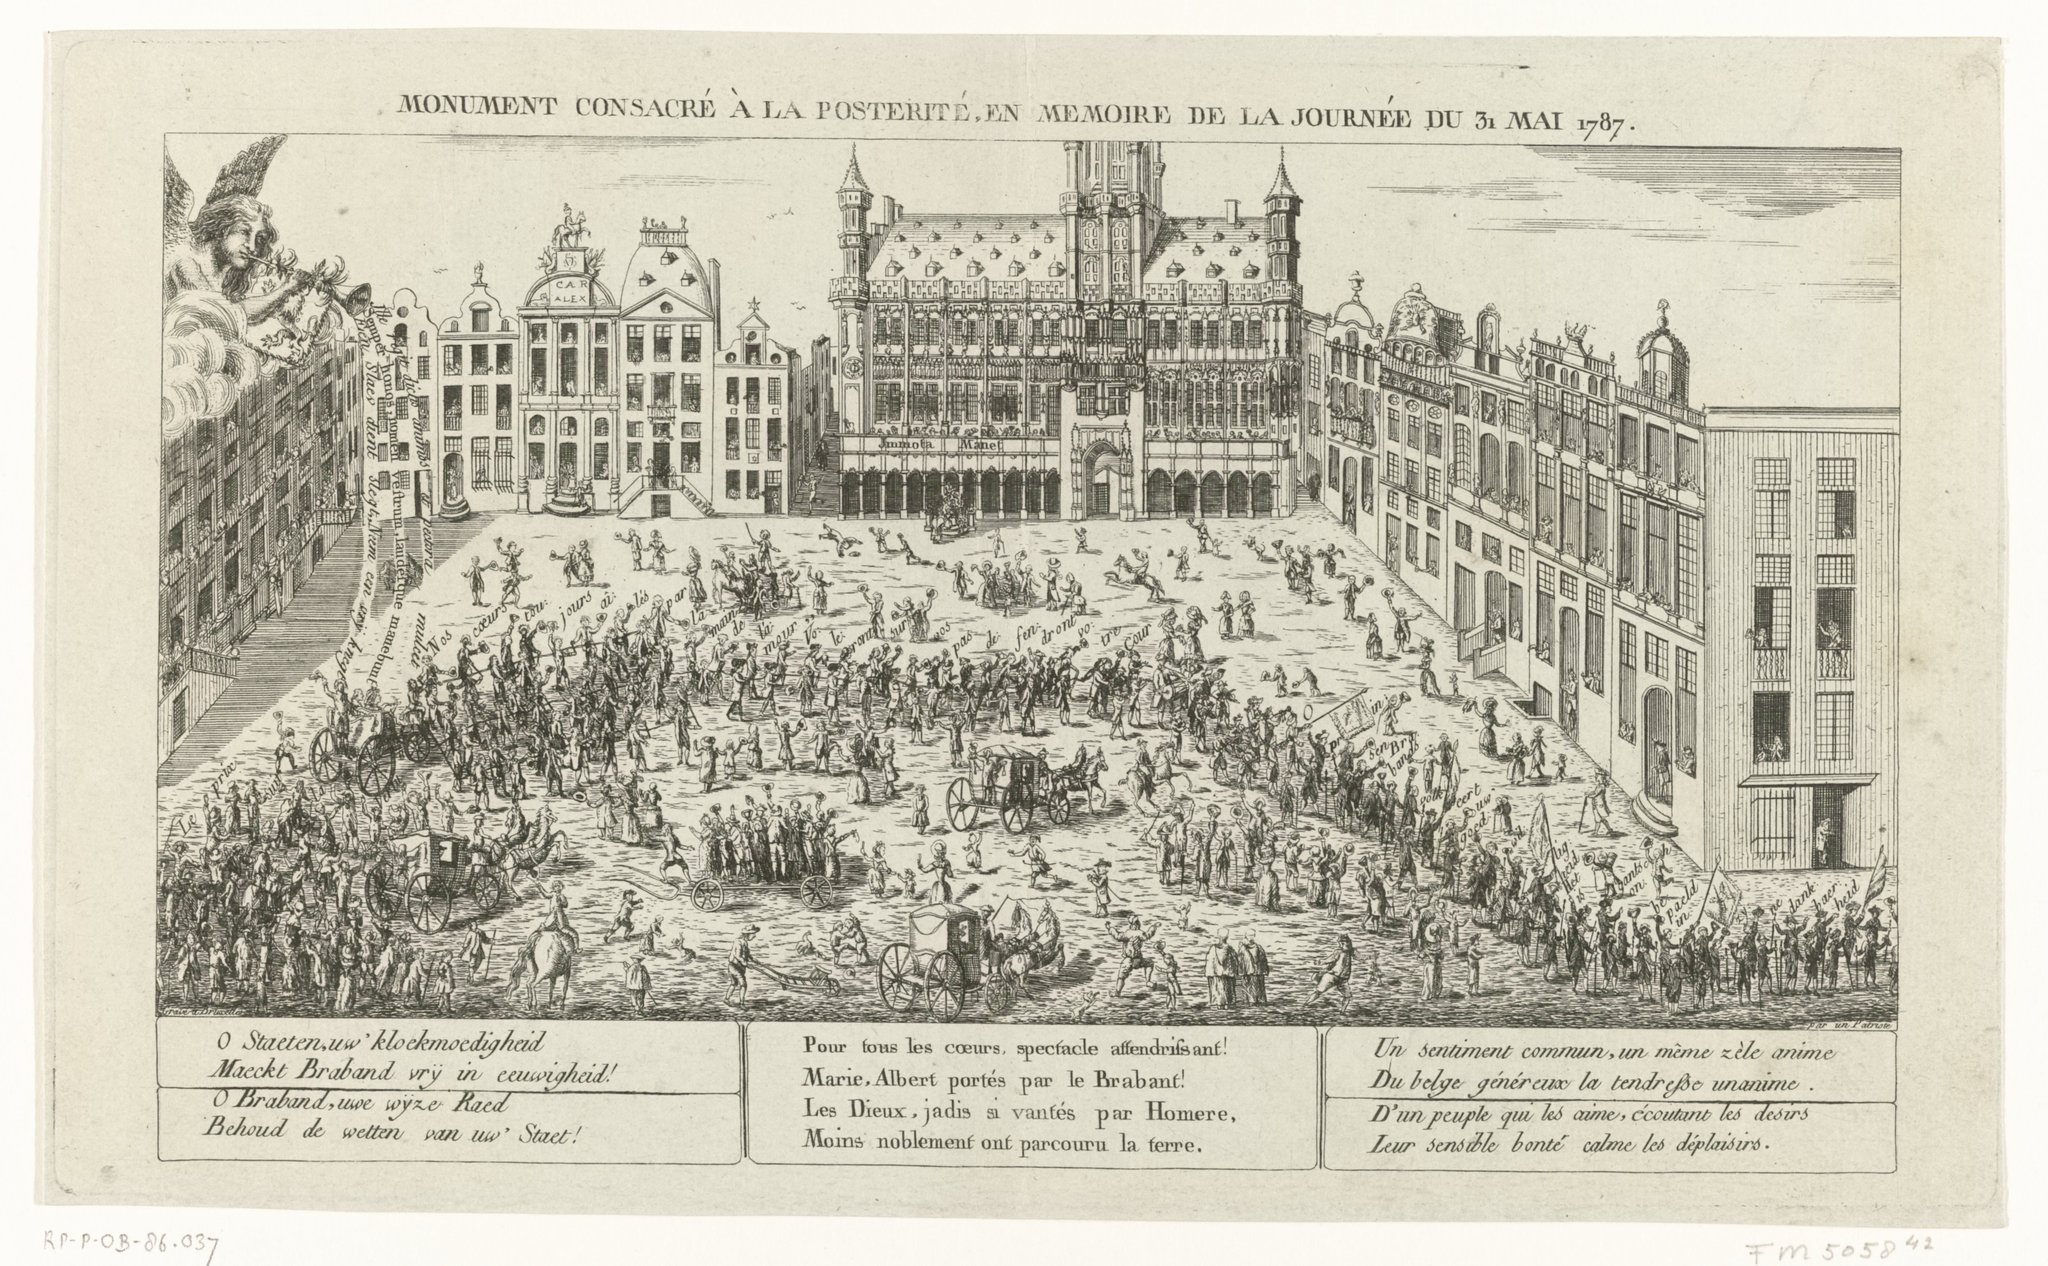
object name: print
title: Brabantse Omwenteling, 1787-1790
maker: Anonymous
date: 1787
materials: paper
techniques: engraving, etching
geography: brussels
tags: revolutionary government, brabant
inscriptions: collector's mark: Lugt 2228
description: Gezicht op de Grote Markt van Brussel waar het volk bijeen is gekomen om de Staten van Brabant toe te juichen op 31 mei 1787. Met onderschriften in het Nederlands en Frans. Onderdeel van een grote groep van prenten betrekking hebbend op de gebeurtenissen van de Brabantse Omwenteling en de periode 1787-1790.